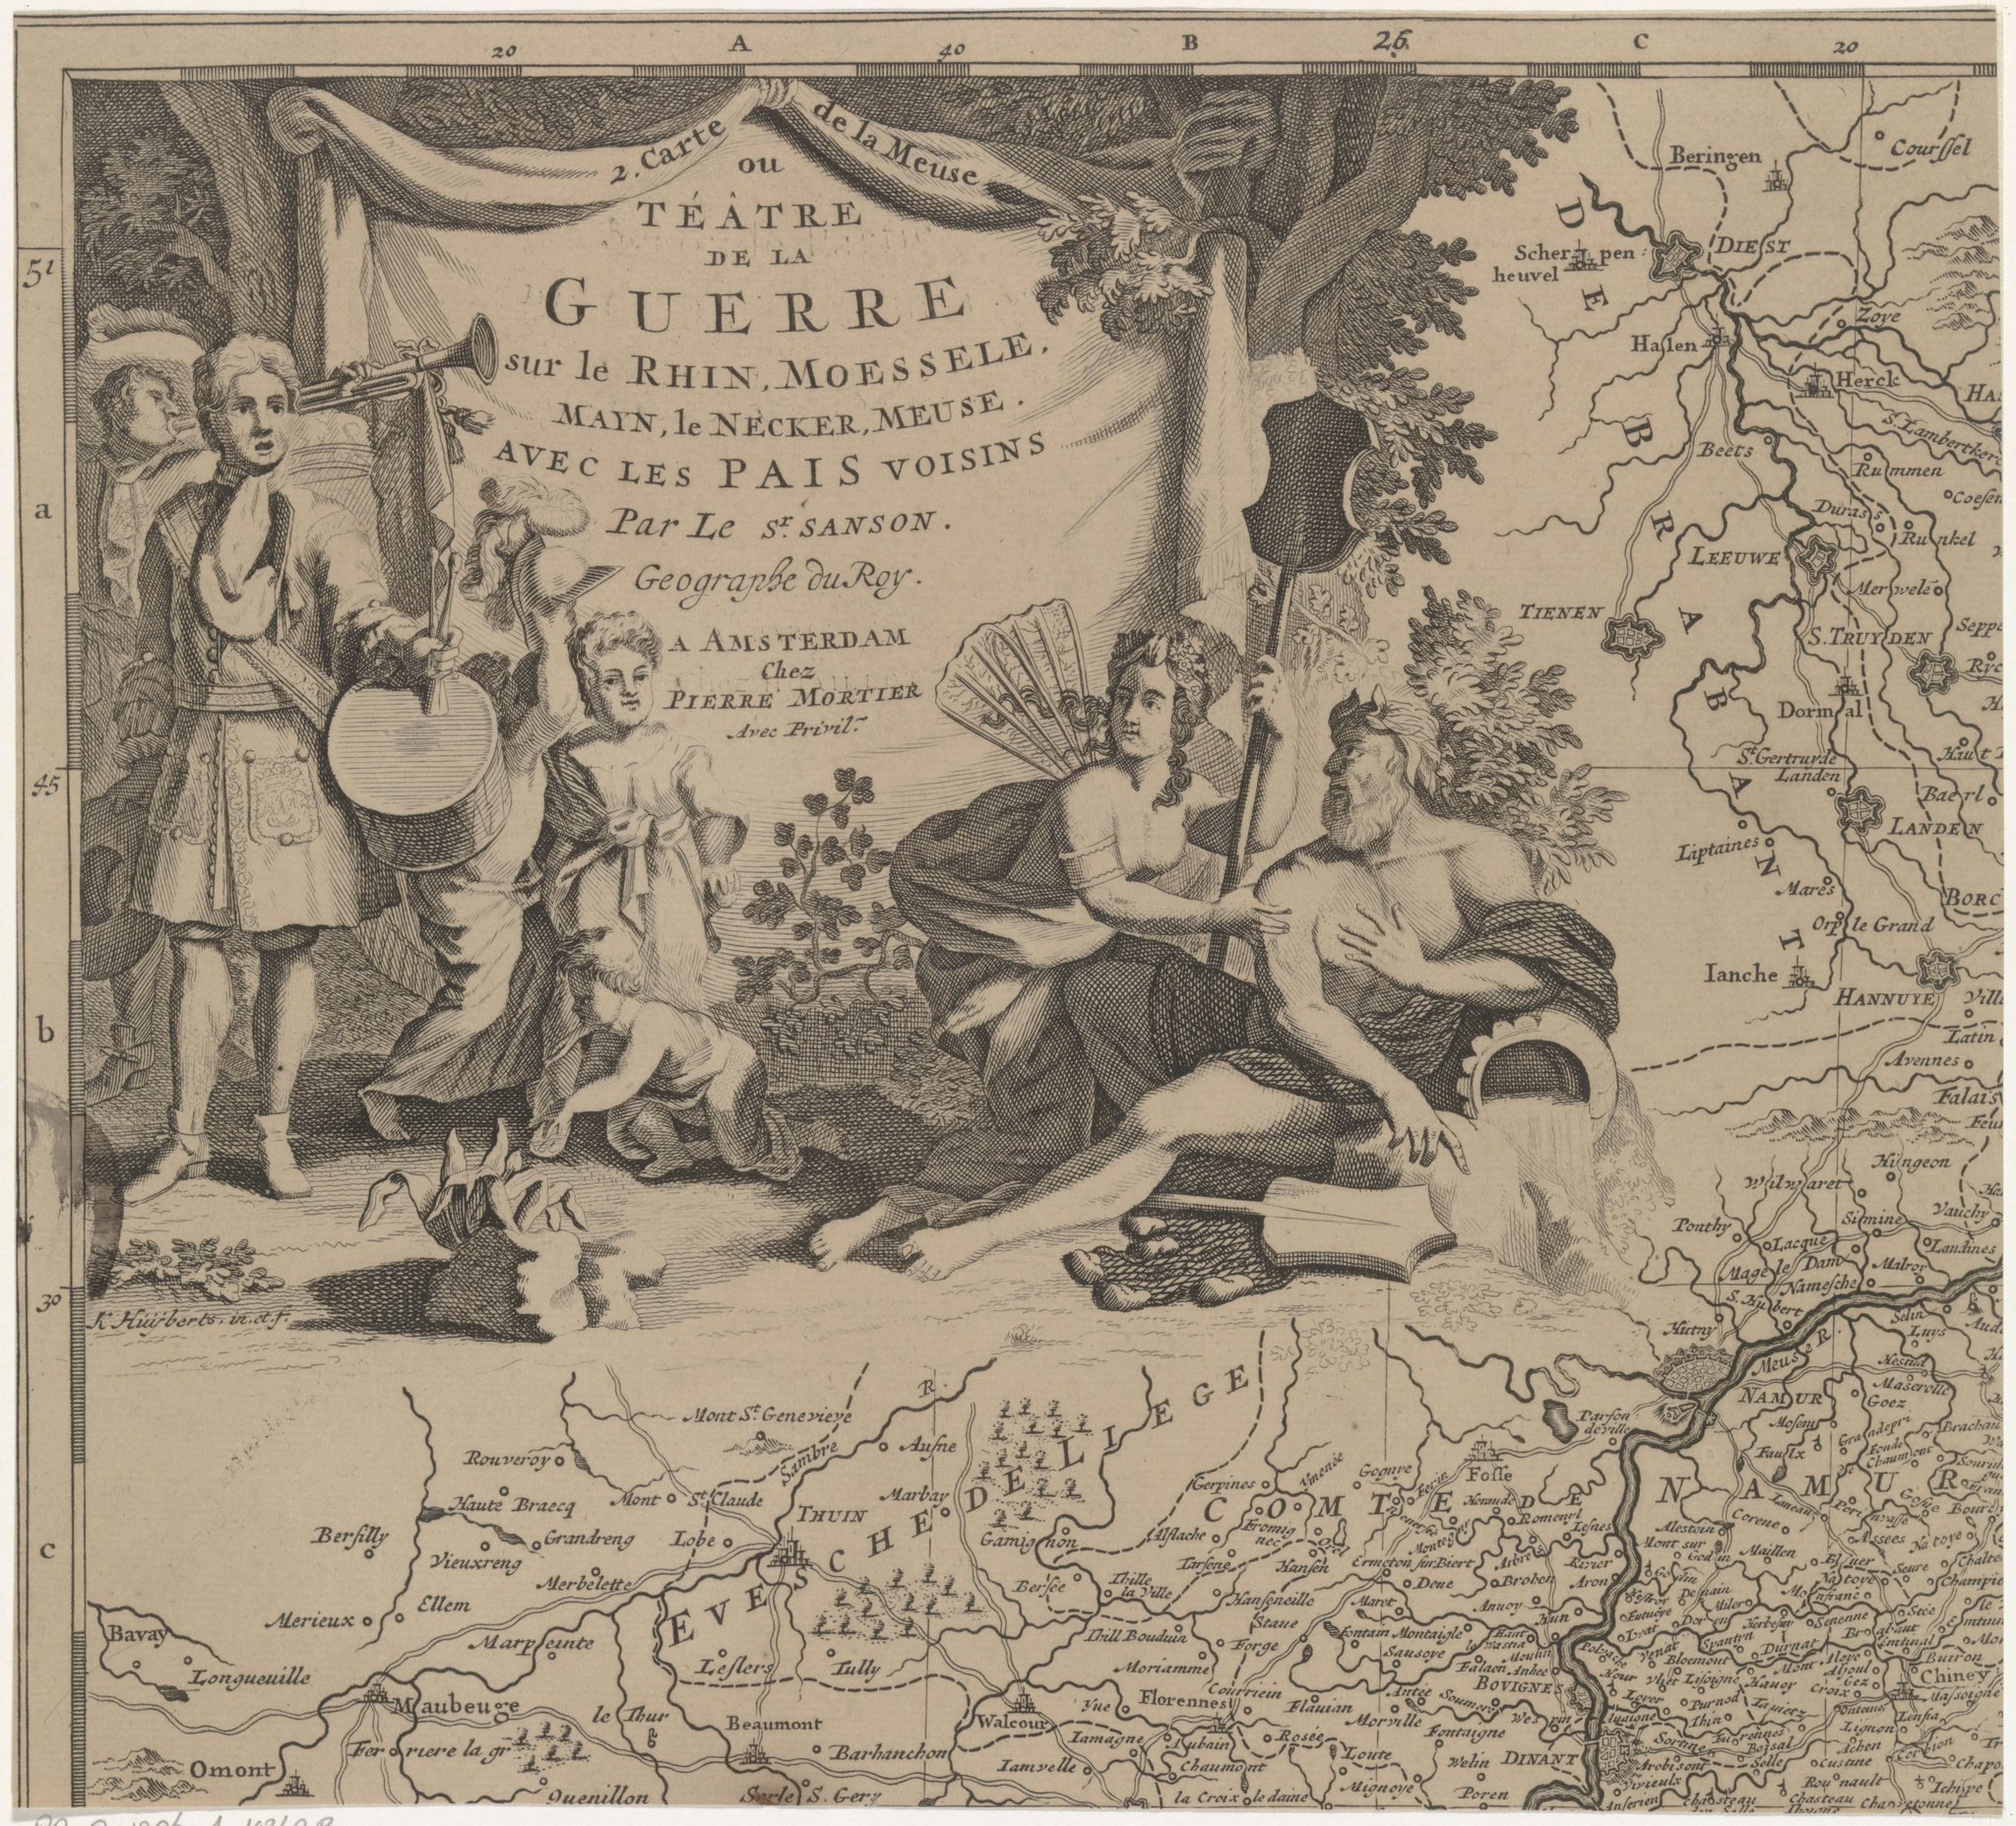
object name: map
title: Kaart van de regio ten oosten en zuiden van Brussel en het graafschap Namen (blad linksboven)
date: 1689-1712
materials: paper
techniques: engraving, etching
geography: amsterdam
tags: maps of separate countries or regions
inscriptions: collector's mark: Lugt 2228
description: In de linkerbovenhoek een vaandel met de titel. Links daarvan een man met trompet en een man met trommel. Een putto kroont een andere putto met de helm van Mars. Rechts Venus en Mars tezamen als allegorie van Schoonheid en Heldenmoed, of van de overwinning van Liefde op Twist. Onder en rechts de kaart van de regio ten oosten en zuiden van Brussel en het graafschap Namen. Mars wijst op het graafschap Namen, wellicht ter herinnering aan de Nederlandse bezetting van Namen van 1695.